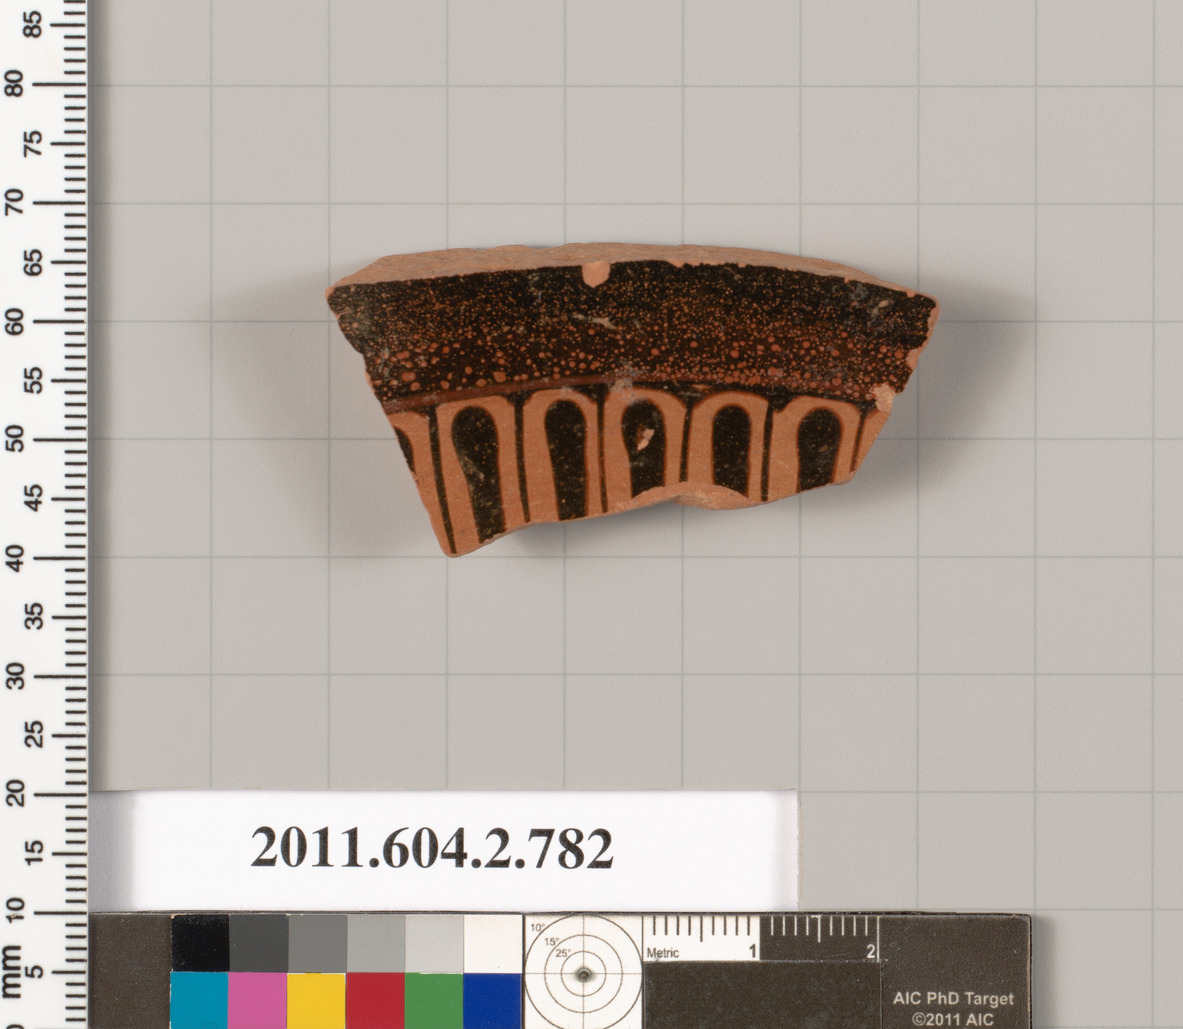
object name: calyx krater fragment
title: Terracotta fragment of a calyx-krater (bowl for mixing wine and water)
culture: greek, attic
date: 490-470 BCE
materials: terracotta